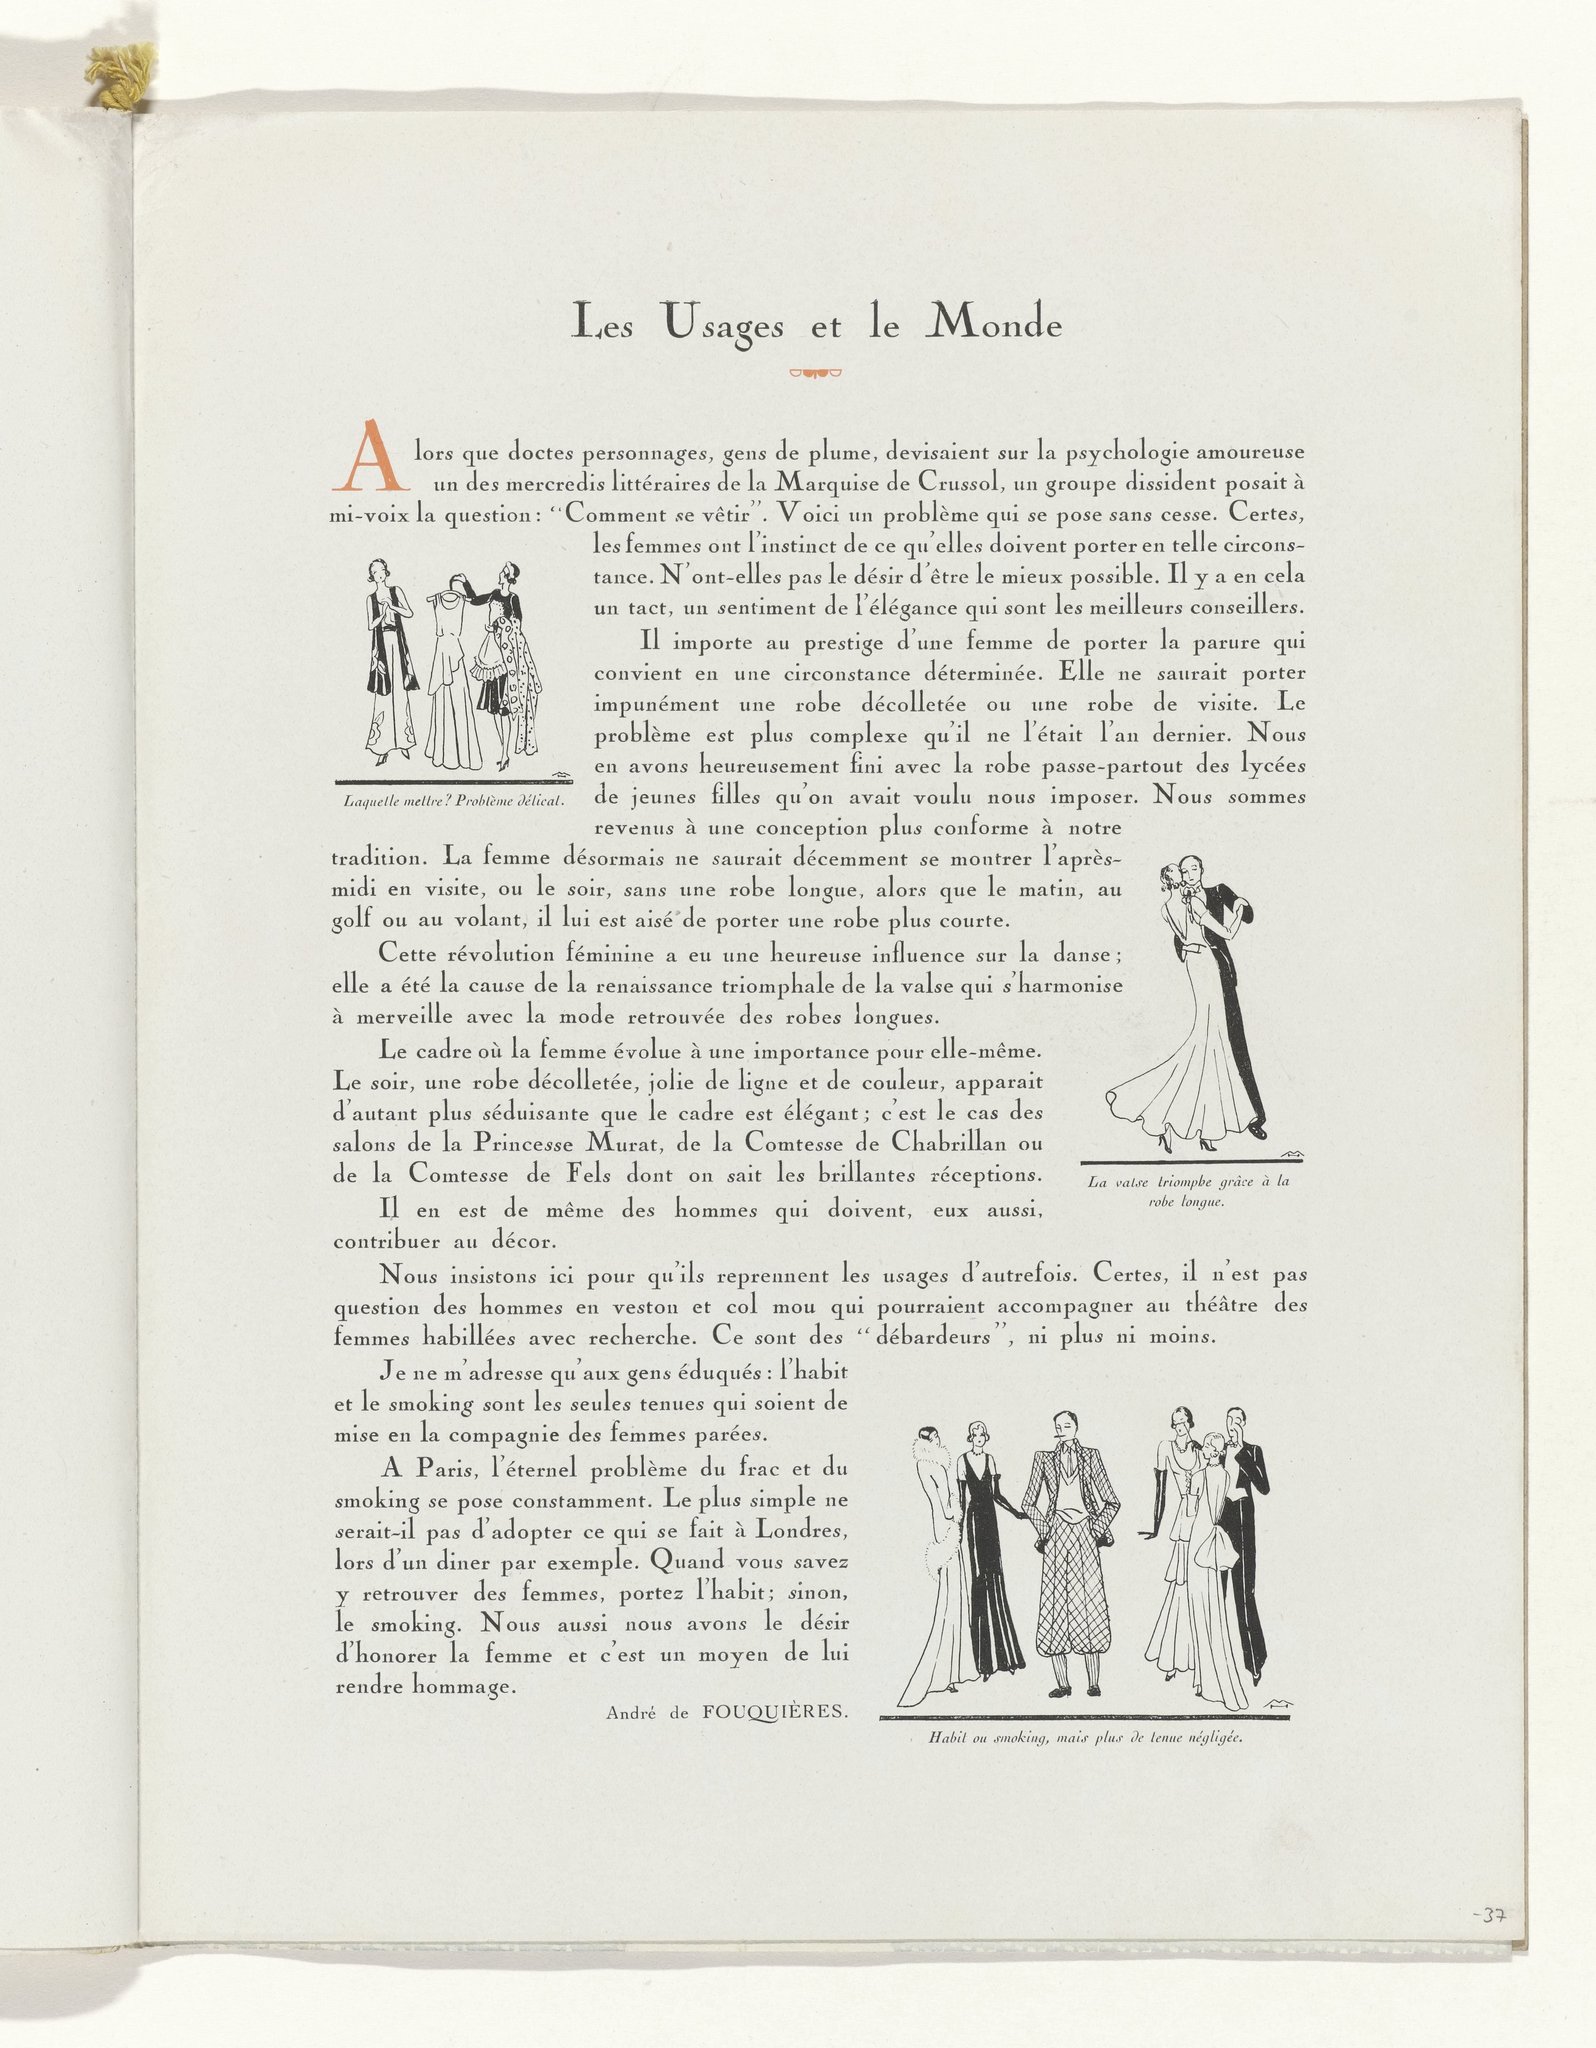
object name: magazine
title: Art - Goût - Beauté, Feuillets de l' élégance féminine, Mai 1931, No. 129, 11e Année, p. 37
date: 1931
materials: paper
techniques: printing, photography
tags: dress, gown: evening dress (+ women's clothes), fashion plates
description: Tekst 'Les Usages et le Monde' met drie afbeeldingen. Pagina uit het modetijdschrift Art-Goût-Beauté (1920-1933).